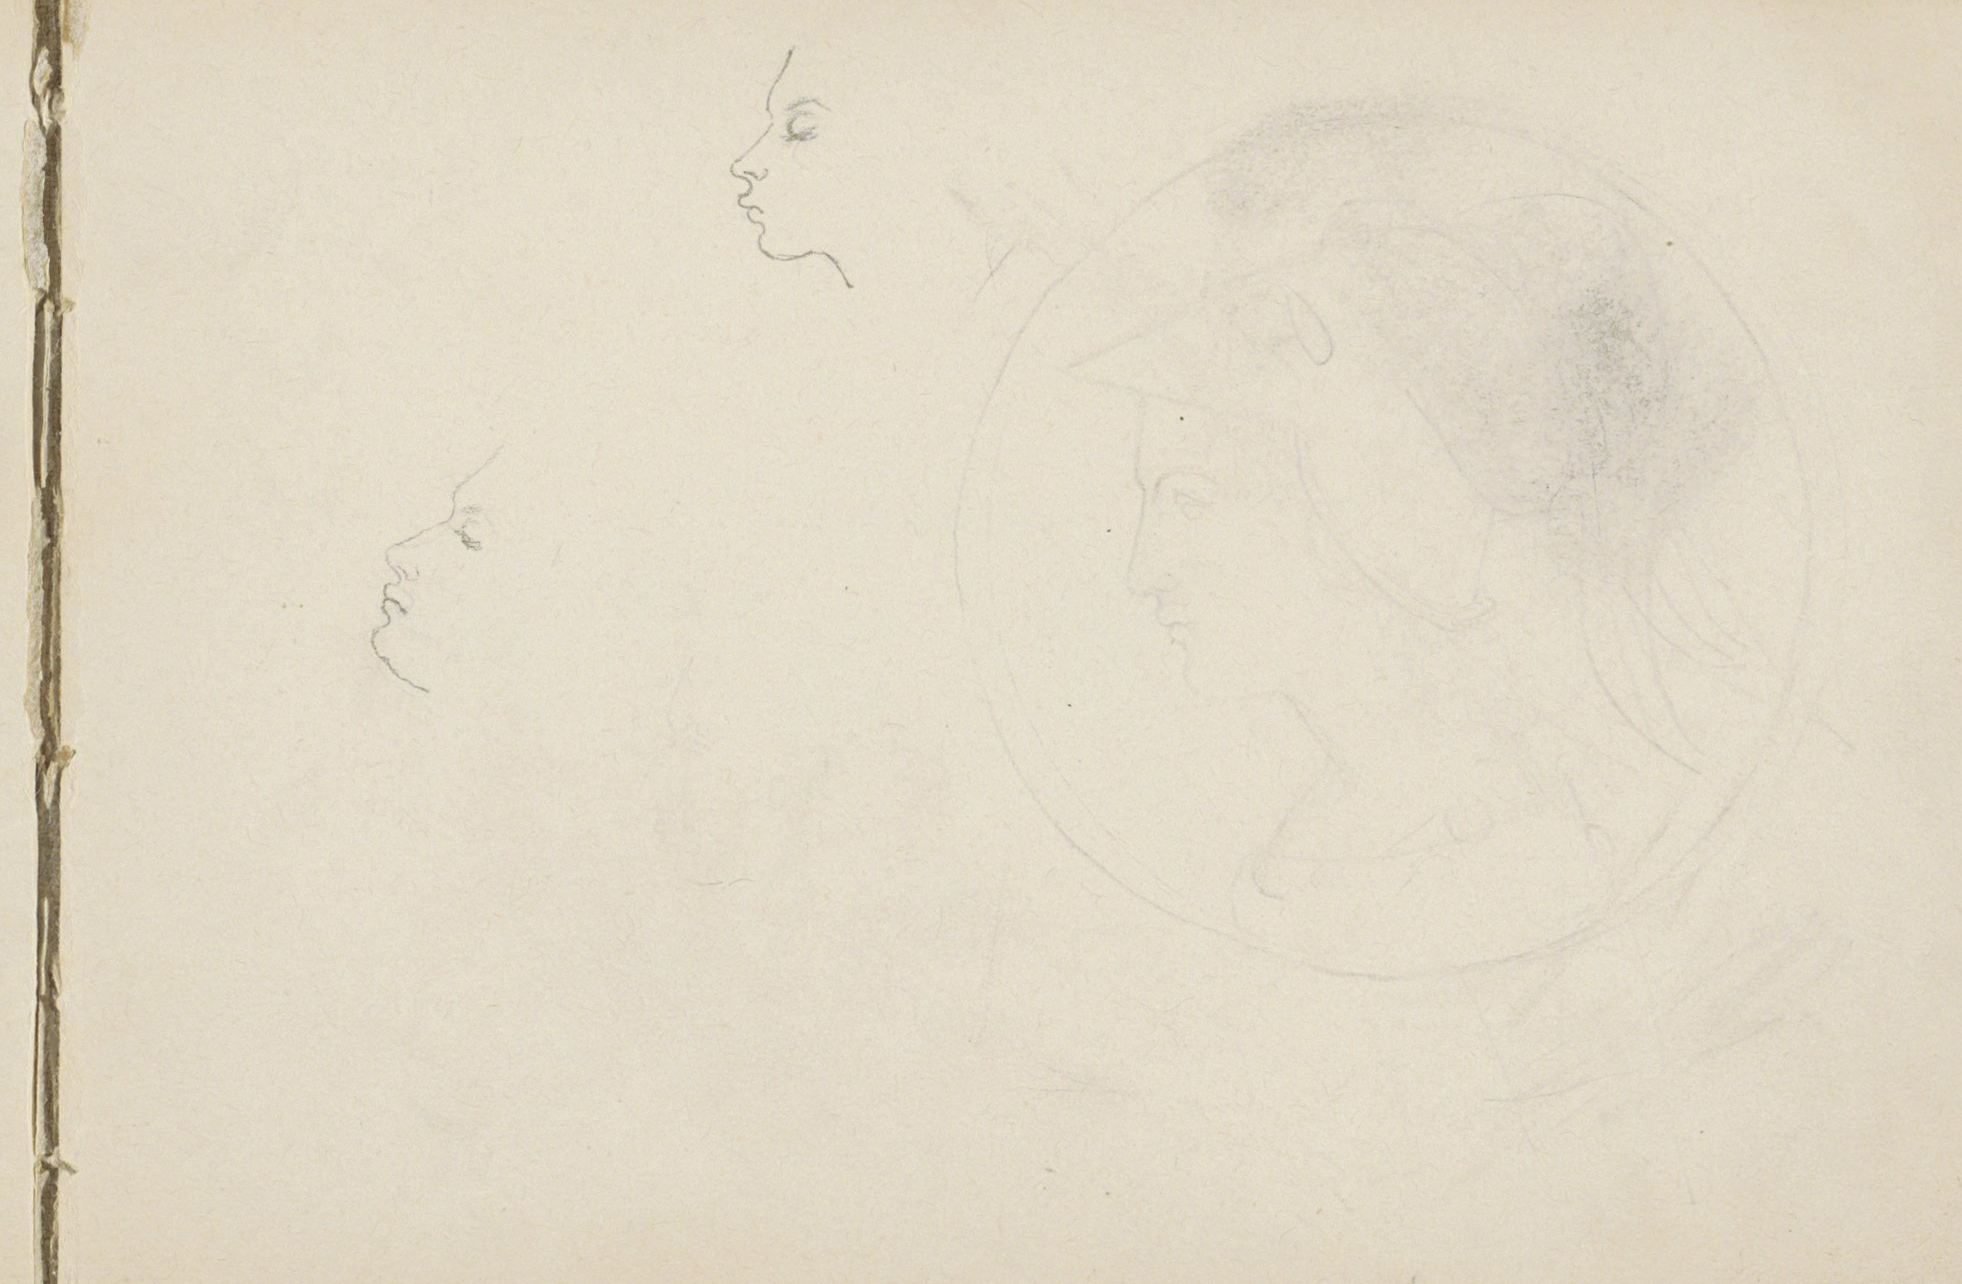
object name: sketchbook leaf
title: Profielen van gezichten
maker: julie de graag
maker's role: draughtsman, print maker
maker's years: 1877-1924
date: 1894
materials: paper, pencil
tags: face, head (human), adult woman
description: Tevens in een cirkel een profiel van een vrouw met een hoed, vermoedelijk Minerva. Blad 9 recto uit een schetsboek met 35 bladen.